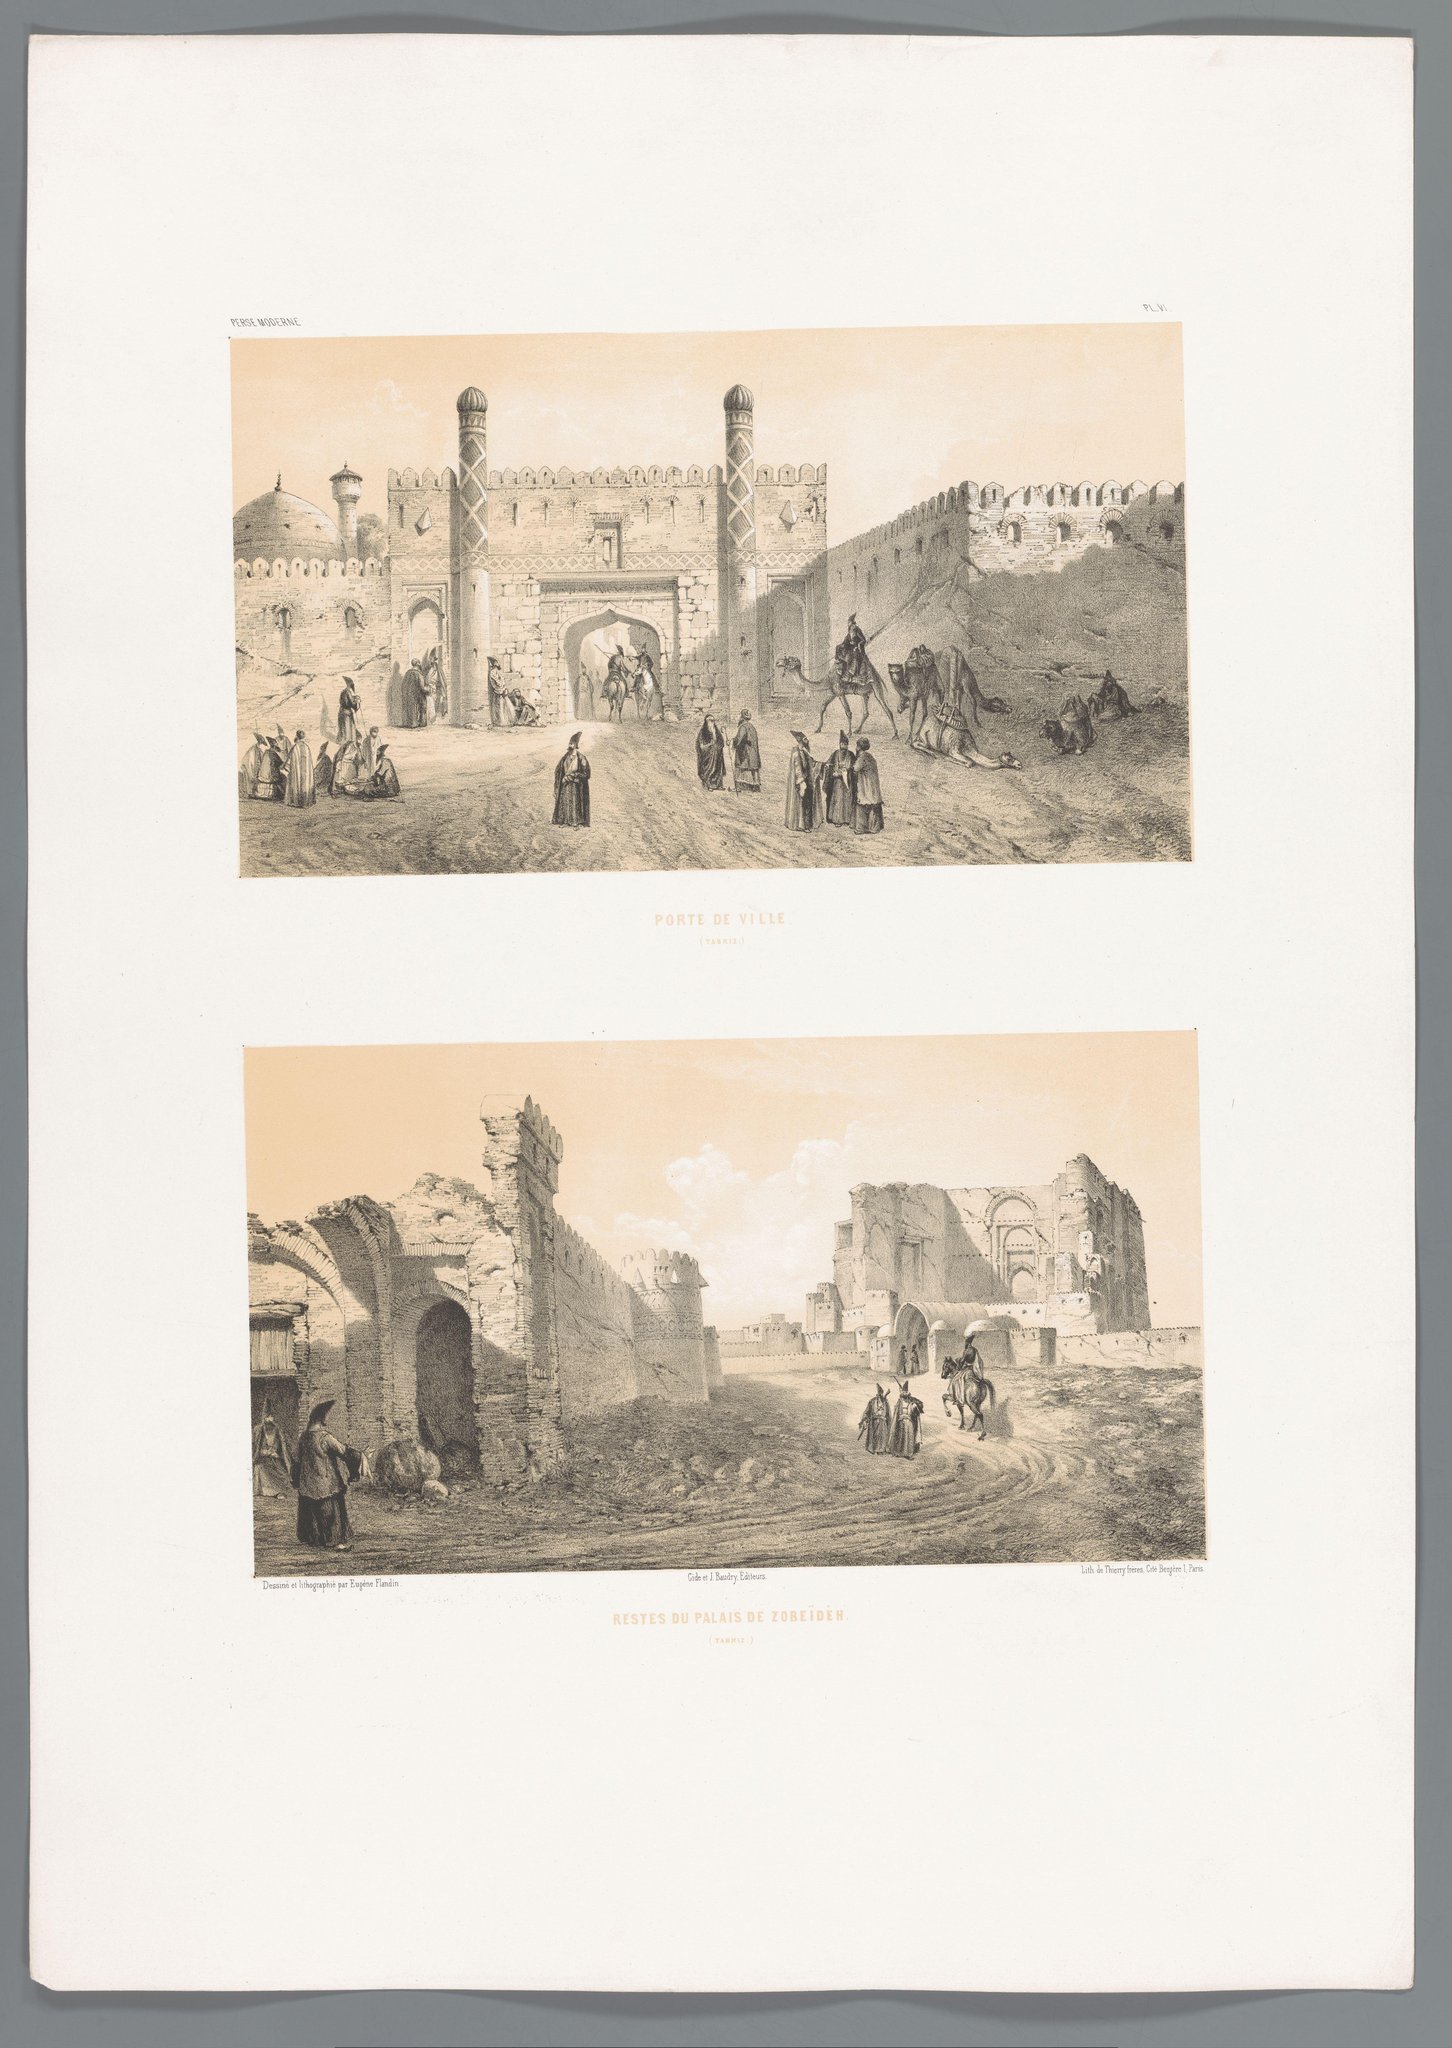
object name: print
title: Restes du palais de Zobeïden (Tabriz)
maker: eugène flandin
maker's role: painter, print maker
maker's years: 1809-1889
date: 1843-1854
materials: paper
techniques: tone lithography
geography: paris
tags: ruin of a building ~ architecture, city-gate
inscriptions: collector's mark: Lugt 2760, collector's mark: Lugt 2228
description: Twee gezichten op Tabriz, met figuren te voet, te paard en op kameel. De bovenste afbeelding een stadspoort, de onderste overblijfselen van een paleis en Arg-e Ali Shah. Linksboven de afbeeldingen de serietitel, rechtsboven het nummer "Pl. VI".